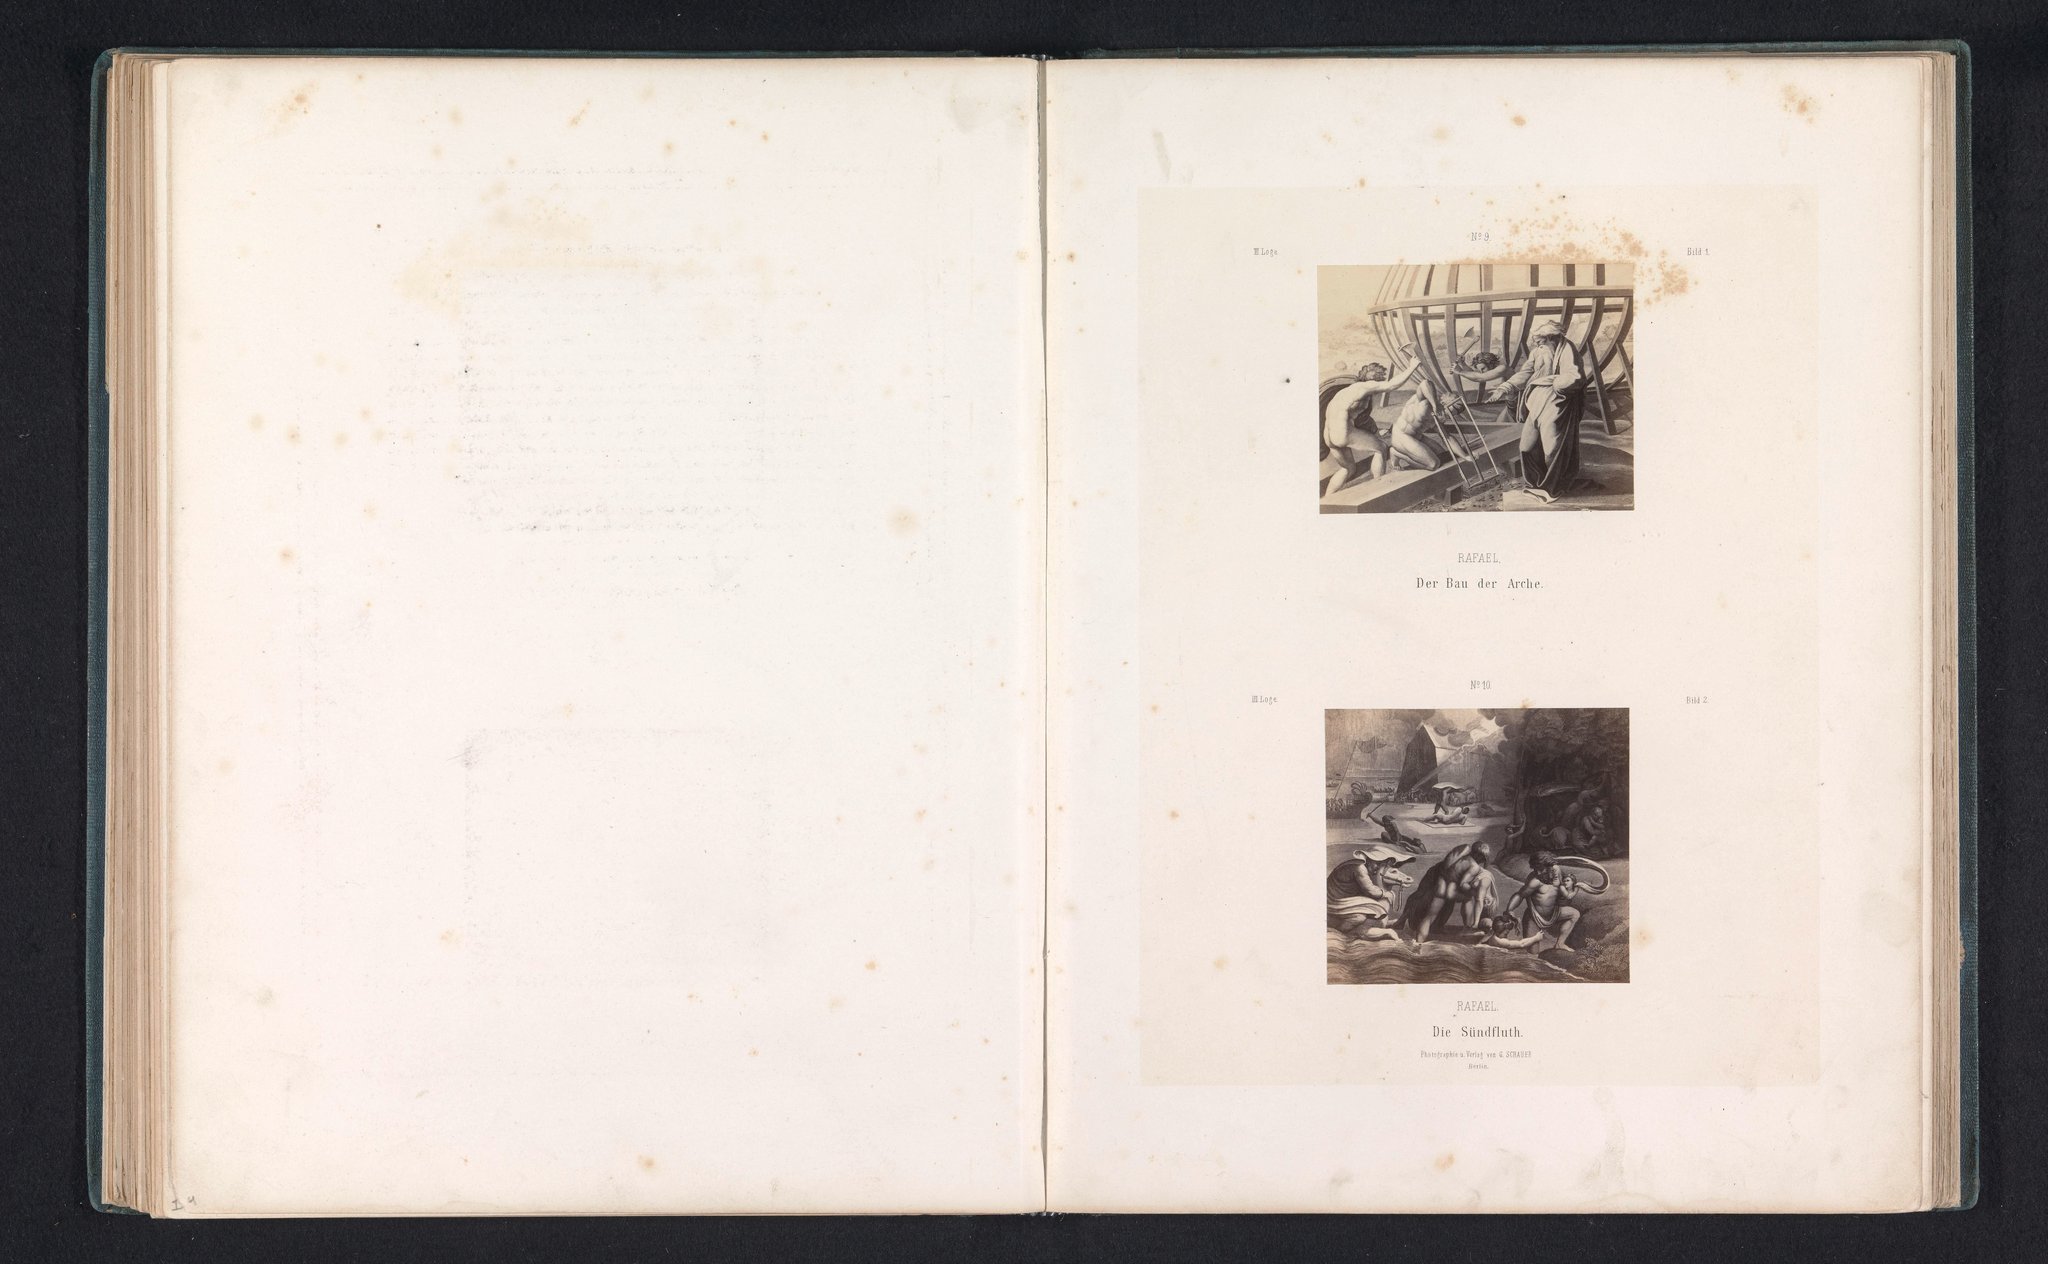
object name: reproduction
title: Fotoreproducties van prenten naar fresco's met voorstellingen van de bouw van de Ark van Noach en de Zondvloed door Rafaël voor de loggia's in het Vaticaan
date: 1851-1861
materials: photographic support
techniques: albumen print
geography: berlin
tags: the flood and destruction of mankind ~ story of noah (genesis 7:10 - 8:17), noah building the ark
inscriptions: number: ‘No 9. No 10. Bild 1. Bild 2. III. Loge.’